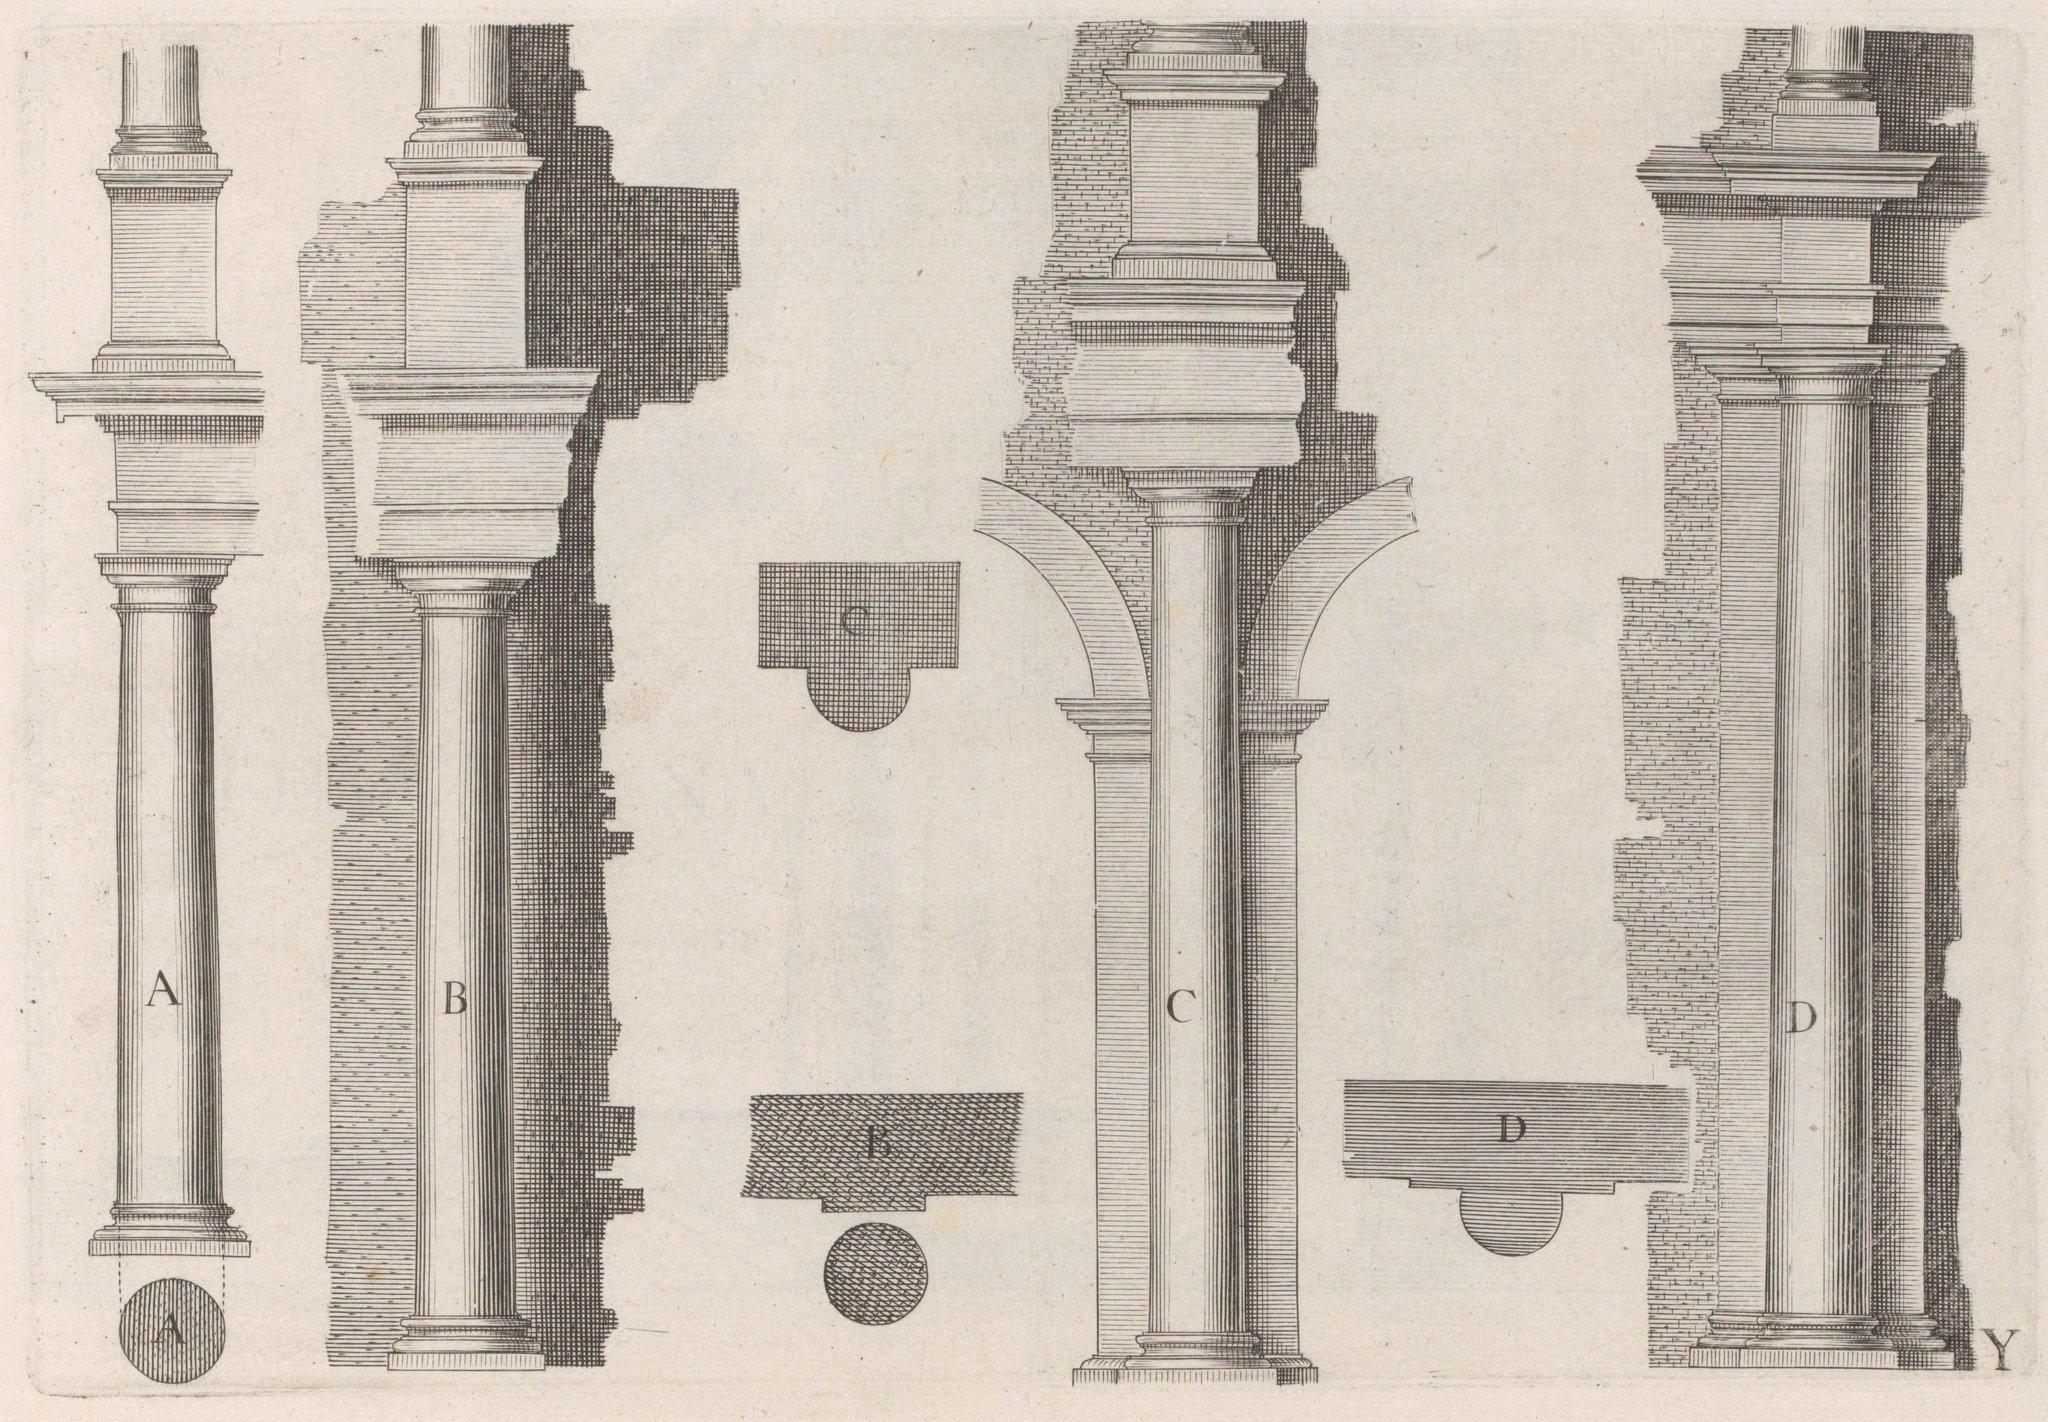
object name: print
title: Architectura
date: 1606-1607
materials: paper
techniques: engraving, etching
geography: the hague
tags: tuscan order ~ architecture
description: Vier manieren om een zuil van de Toscaanse orde tegen een muur te plaatsen, opstand en plattegrond. Rechtsonder: Y. Prent maakt deel uit van een album.